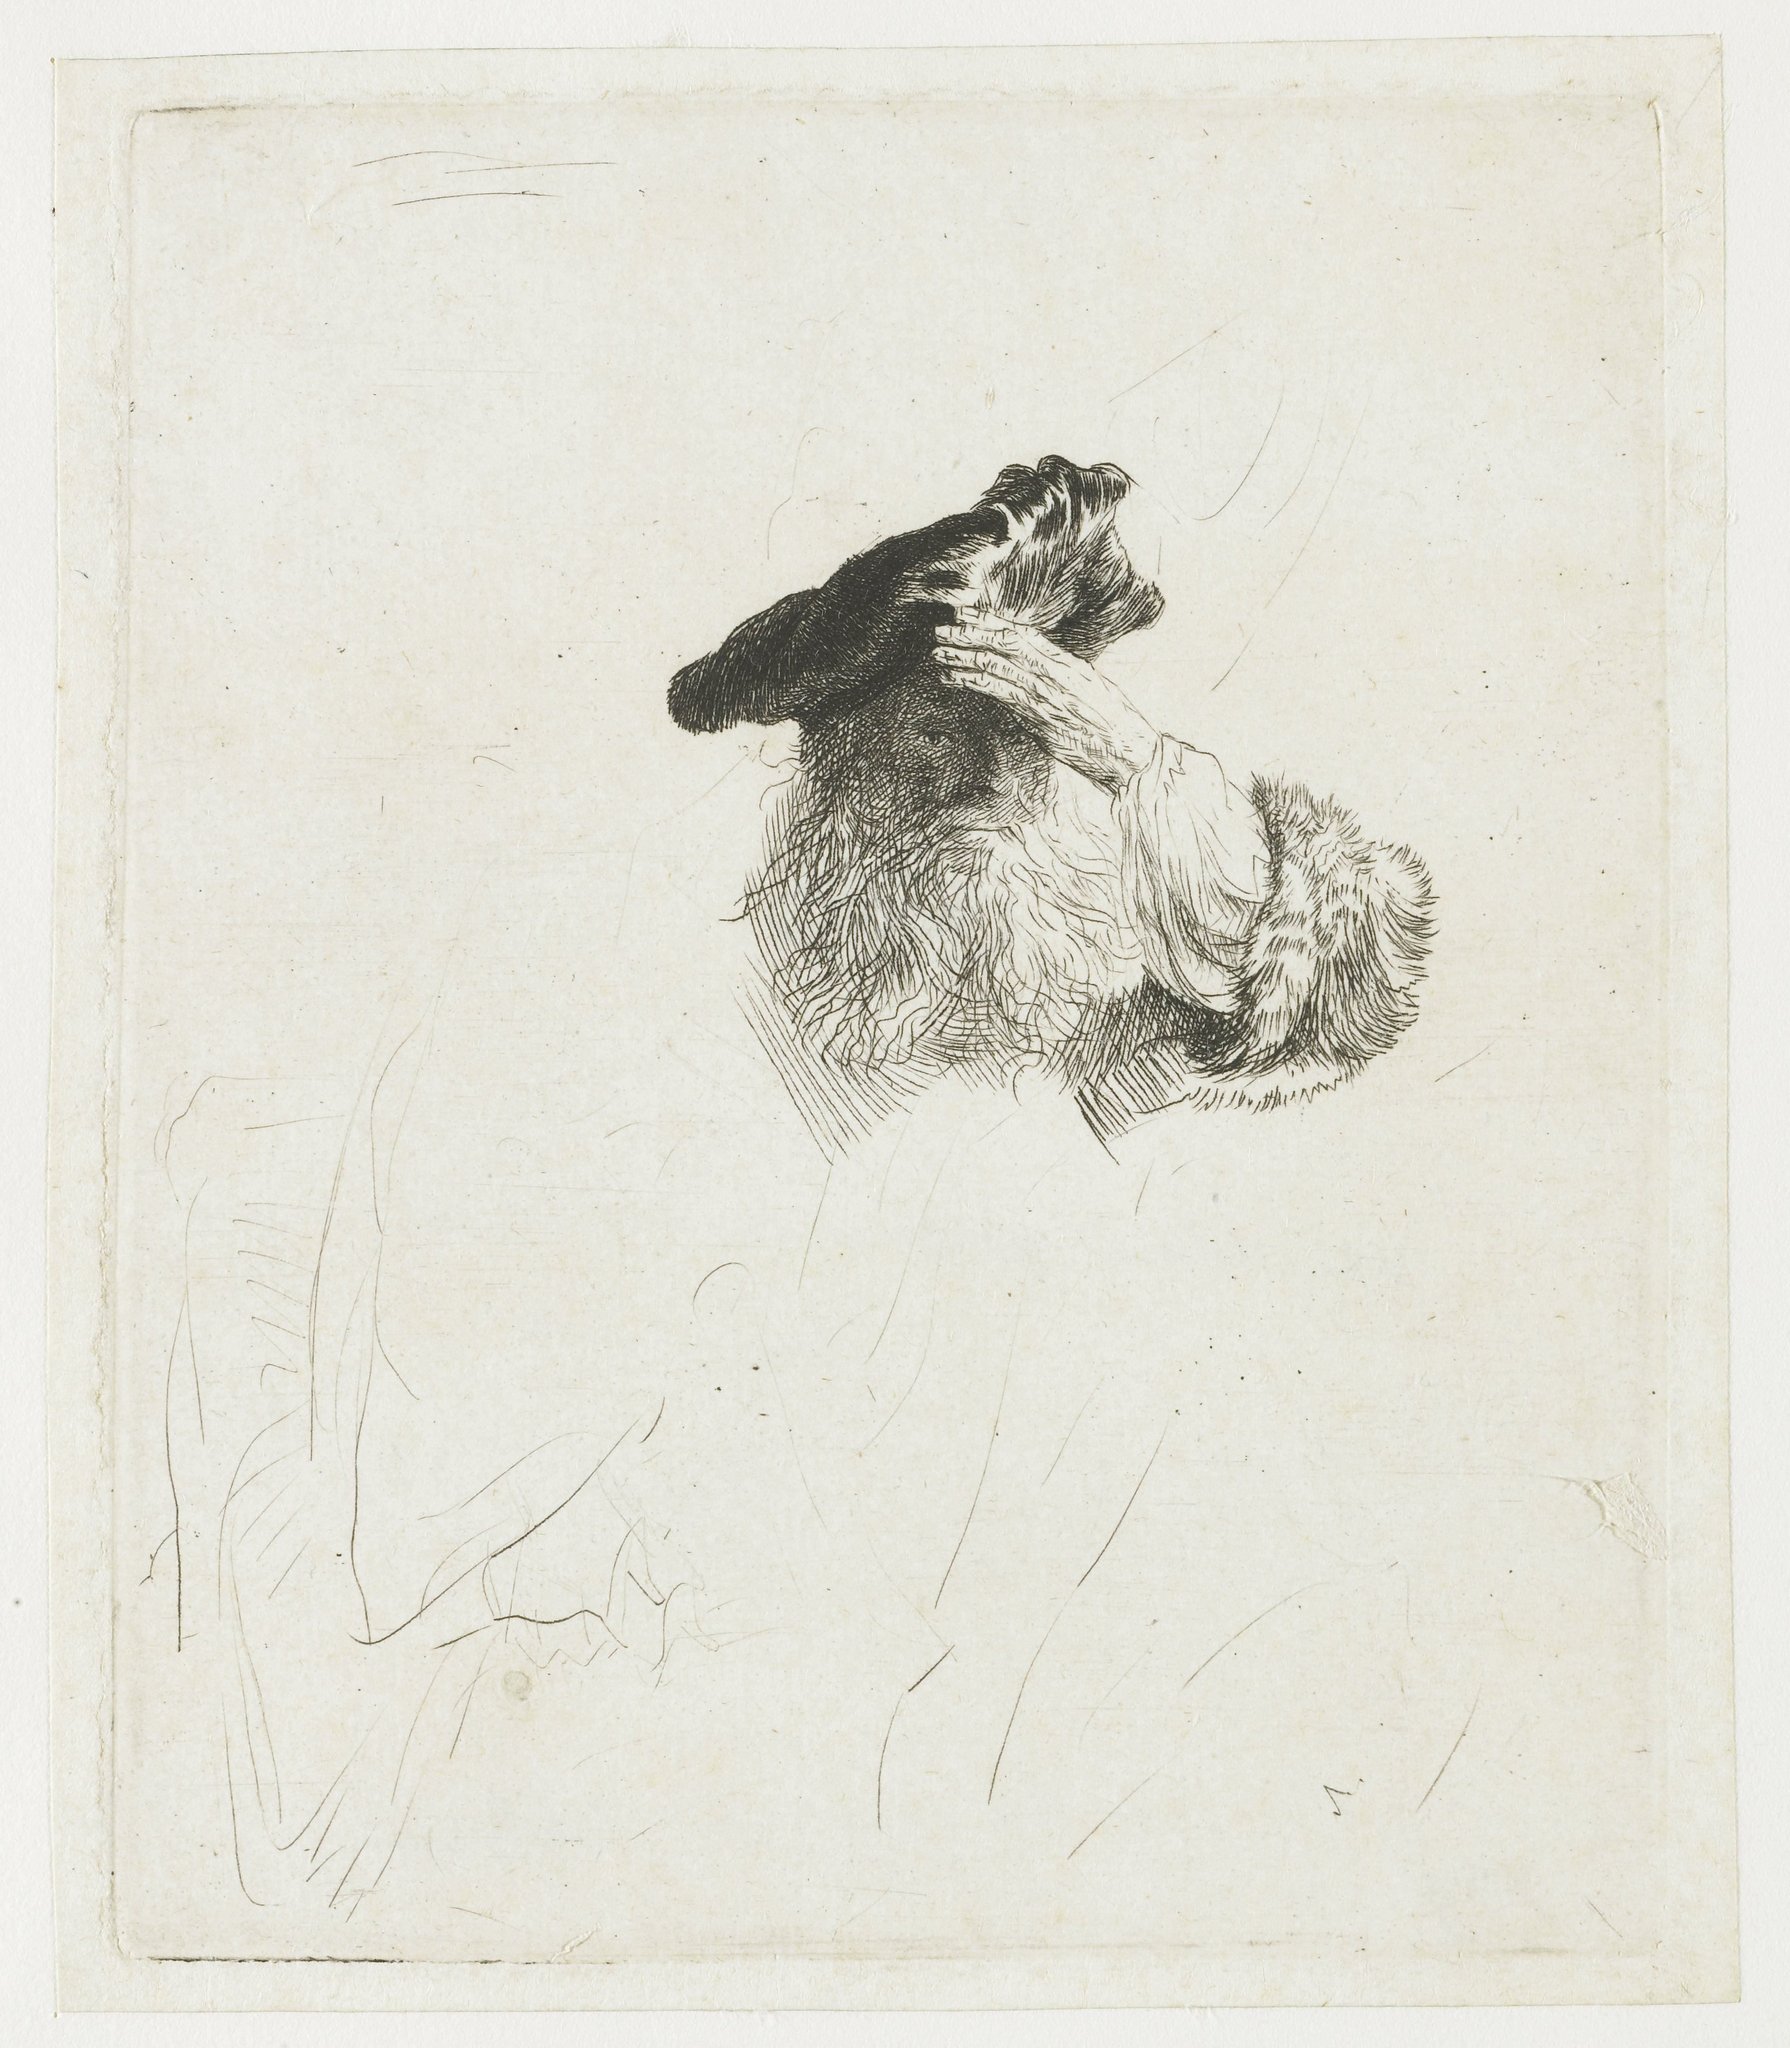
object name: print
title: Old man shading his eyes with his hand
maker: rembrandt van rijn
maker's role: draughtsman, painter, print maker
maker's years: 1606-1669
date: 1639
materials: paper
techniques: drypoint, etching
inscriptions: mark: Lugt 2228